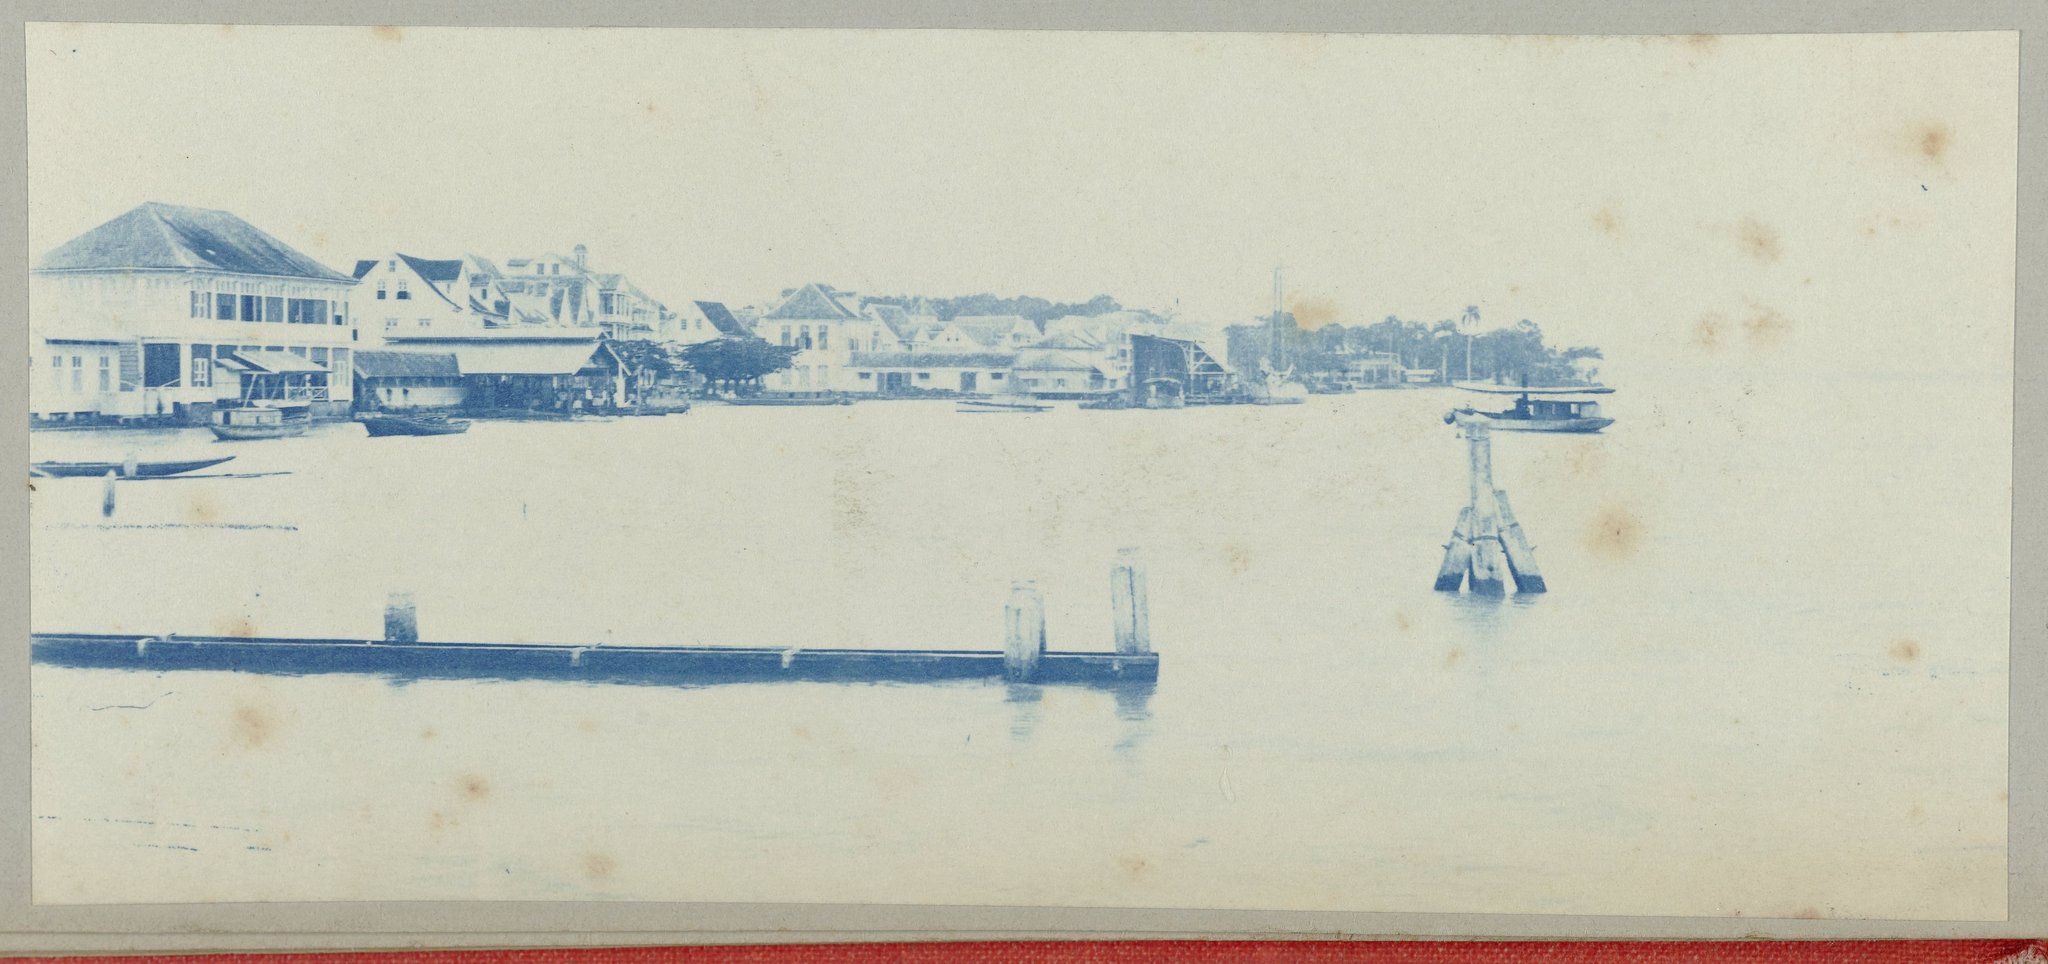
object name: photograph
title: Waterkant Paramaribo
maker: hendrik doijer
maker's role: engineer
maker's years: 1863-1925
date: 1903-1910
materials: photographic support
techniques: cyanotype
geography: suriname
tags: suriname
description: Gezicht op huizen en steigers aan de Waterkant van Paramaribo. Onderdeel van het fotoalbum Souvenir de Voyage (deel 2), over het leven van de familie Doijer in en rond de plantage Ma Retraite in Suriname in de jaren 1903-1910.